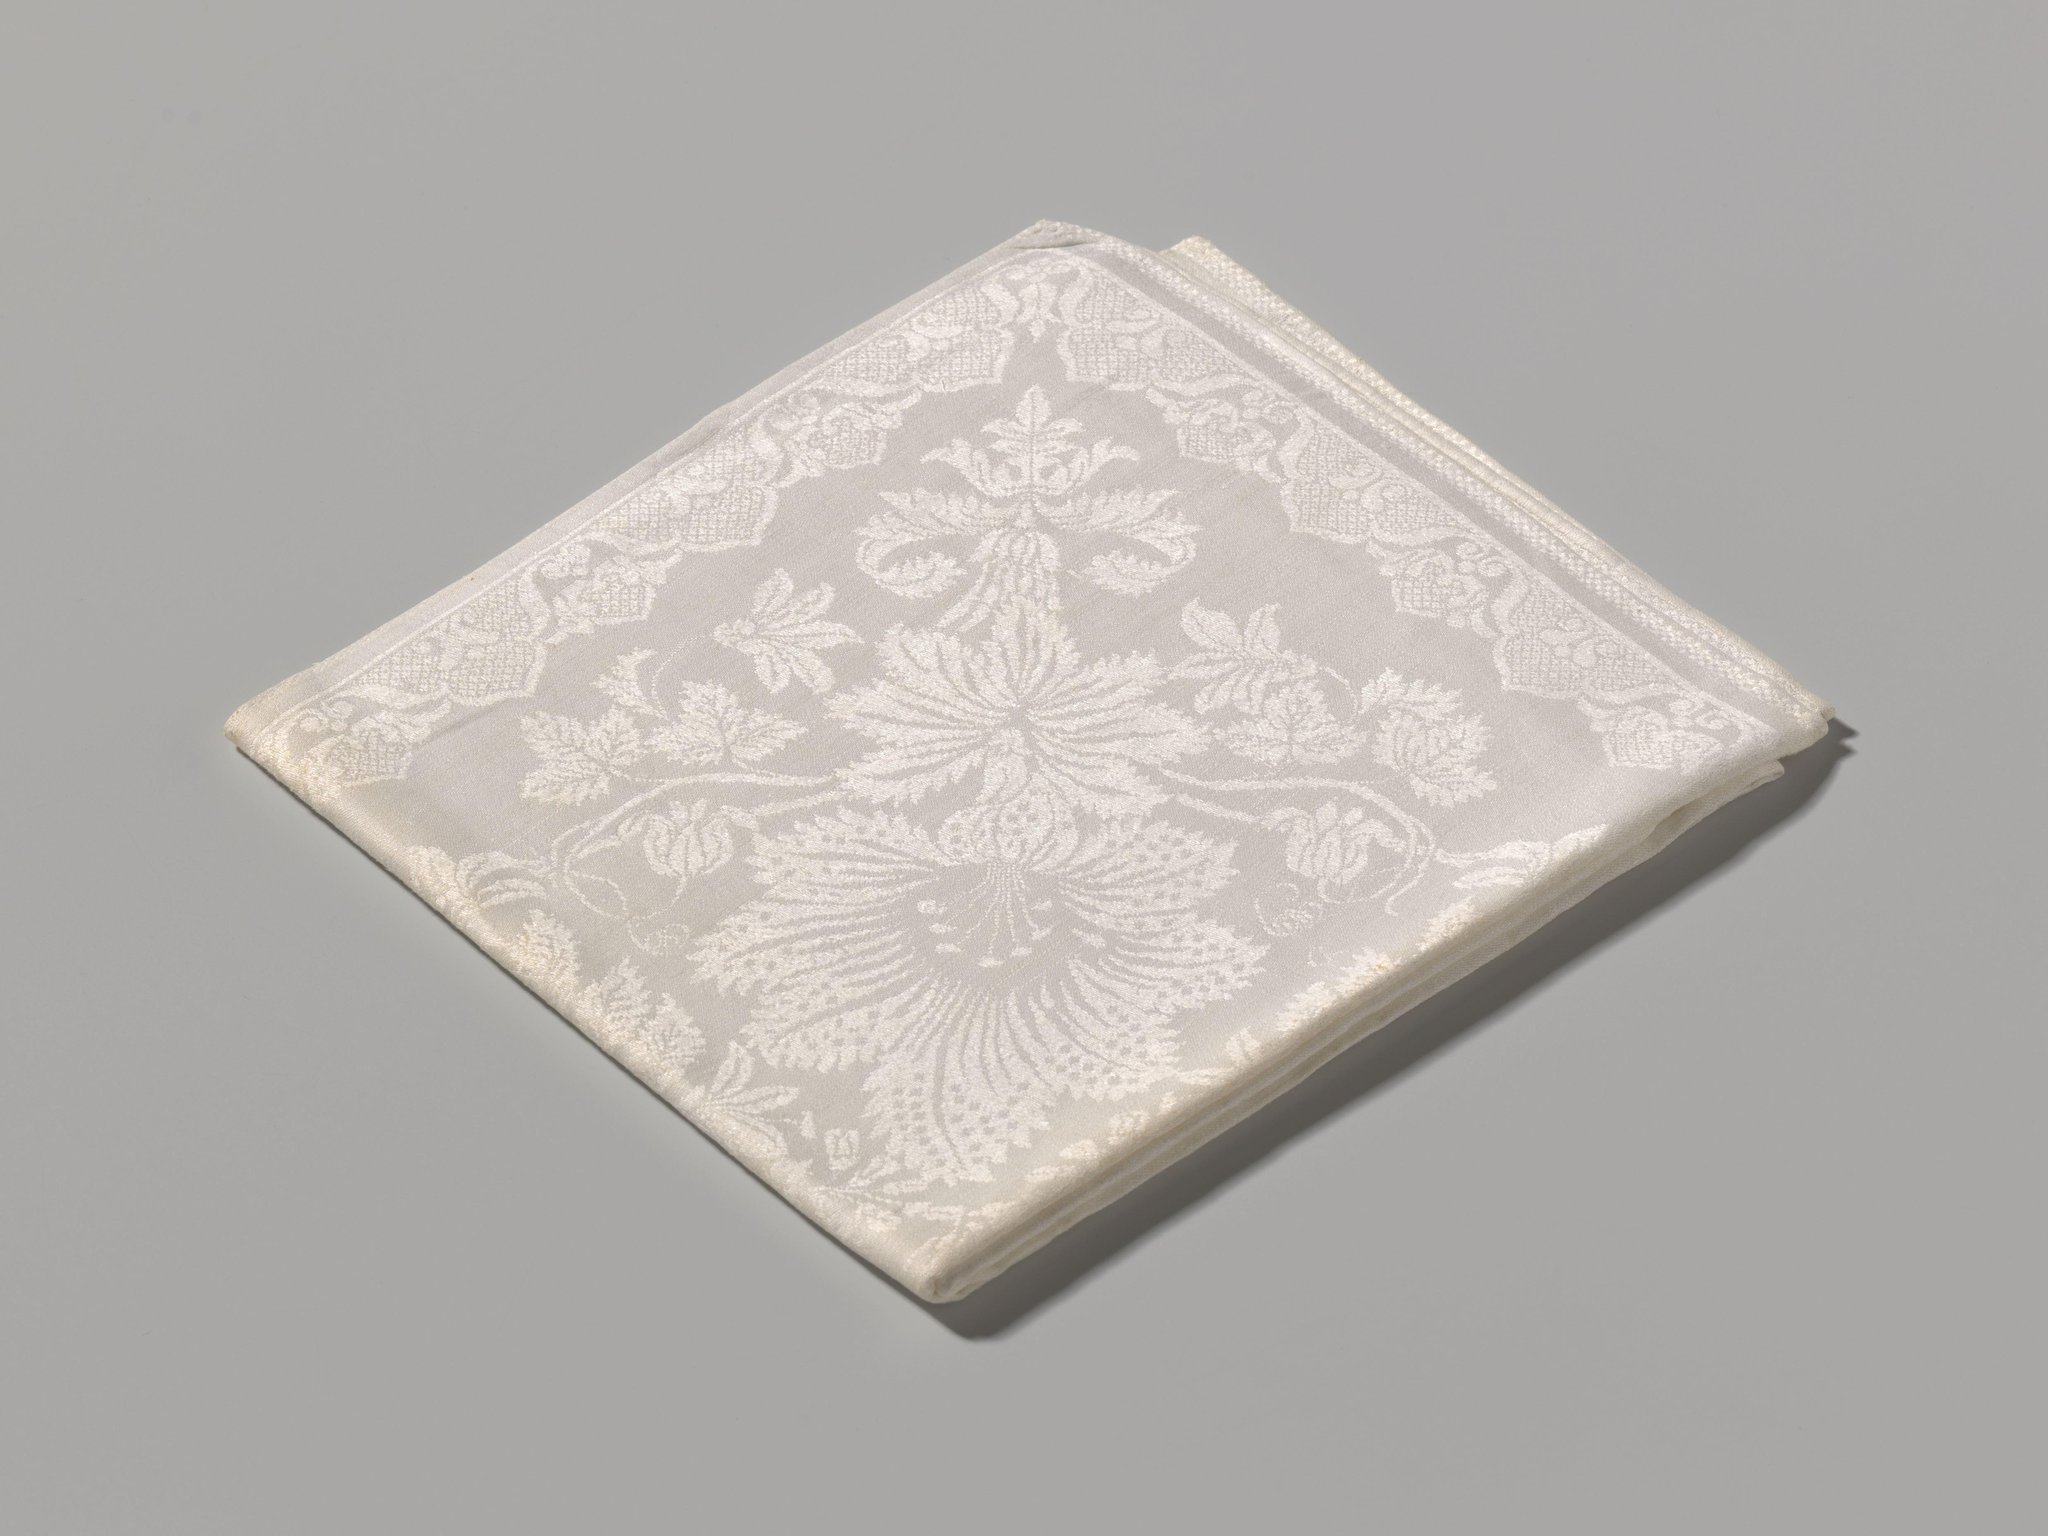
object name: napkin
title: Servet met bloempatroon, gemerkt FS 18.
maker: Anonymous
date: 1850-1880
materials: linen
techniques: damask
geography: netherlands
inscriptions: mark: ‘FS 18’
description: Wit linnen damasten servet met een bloempatroon, gemerkt FS 18.